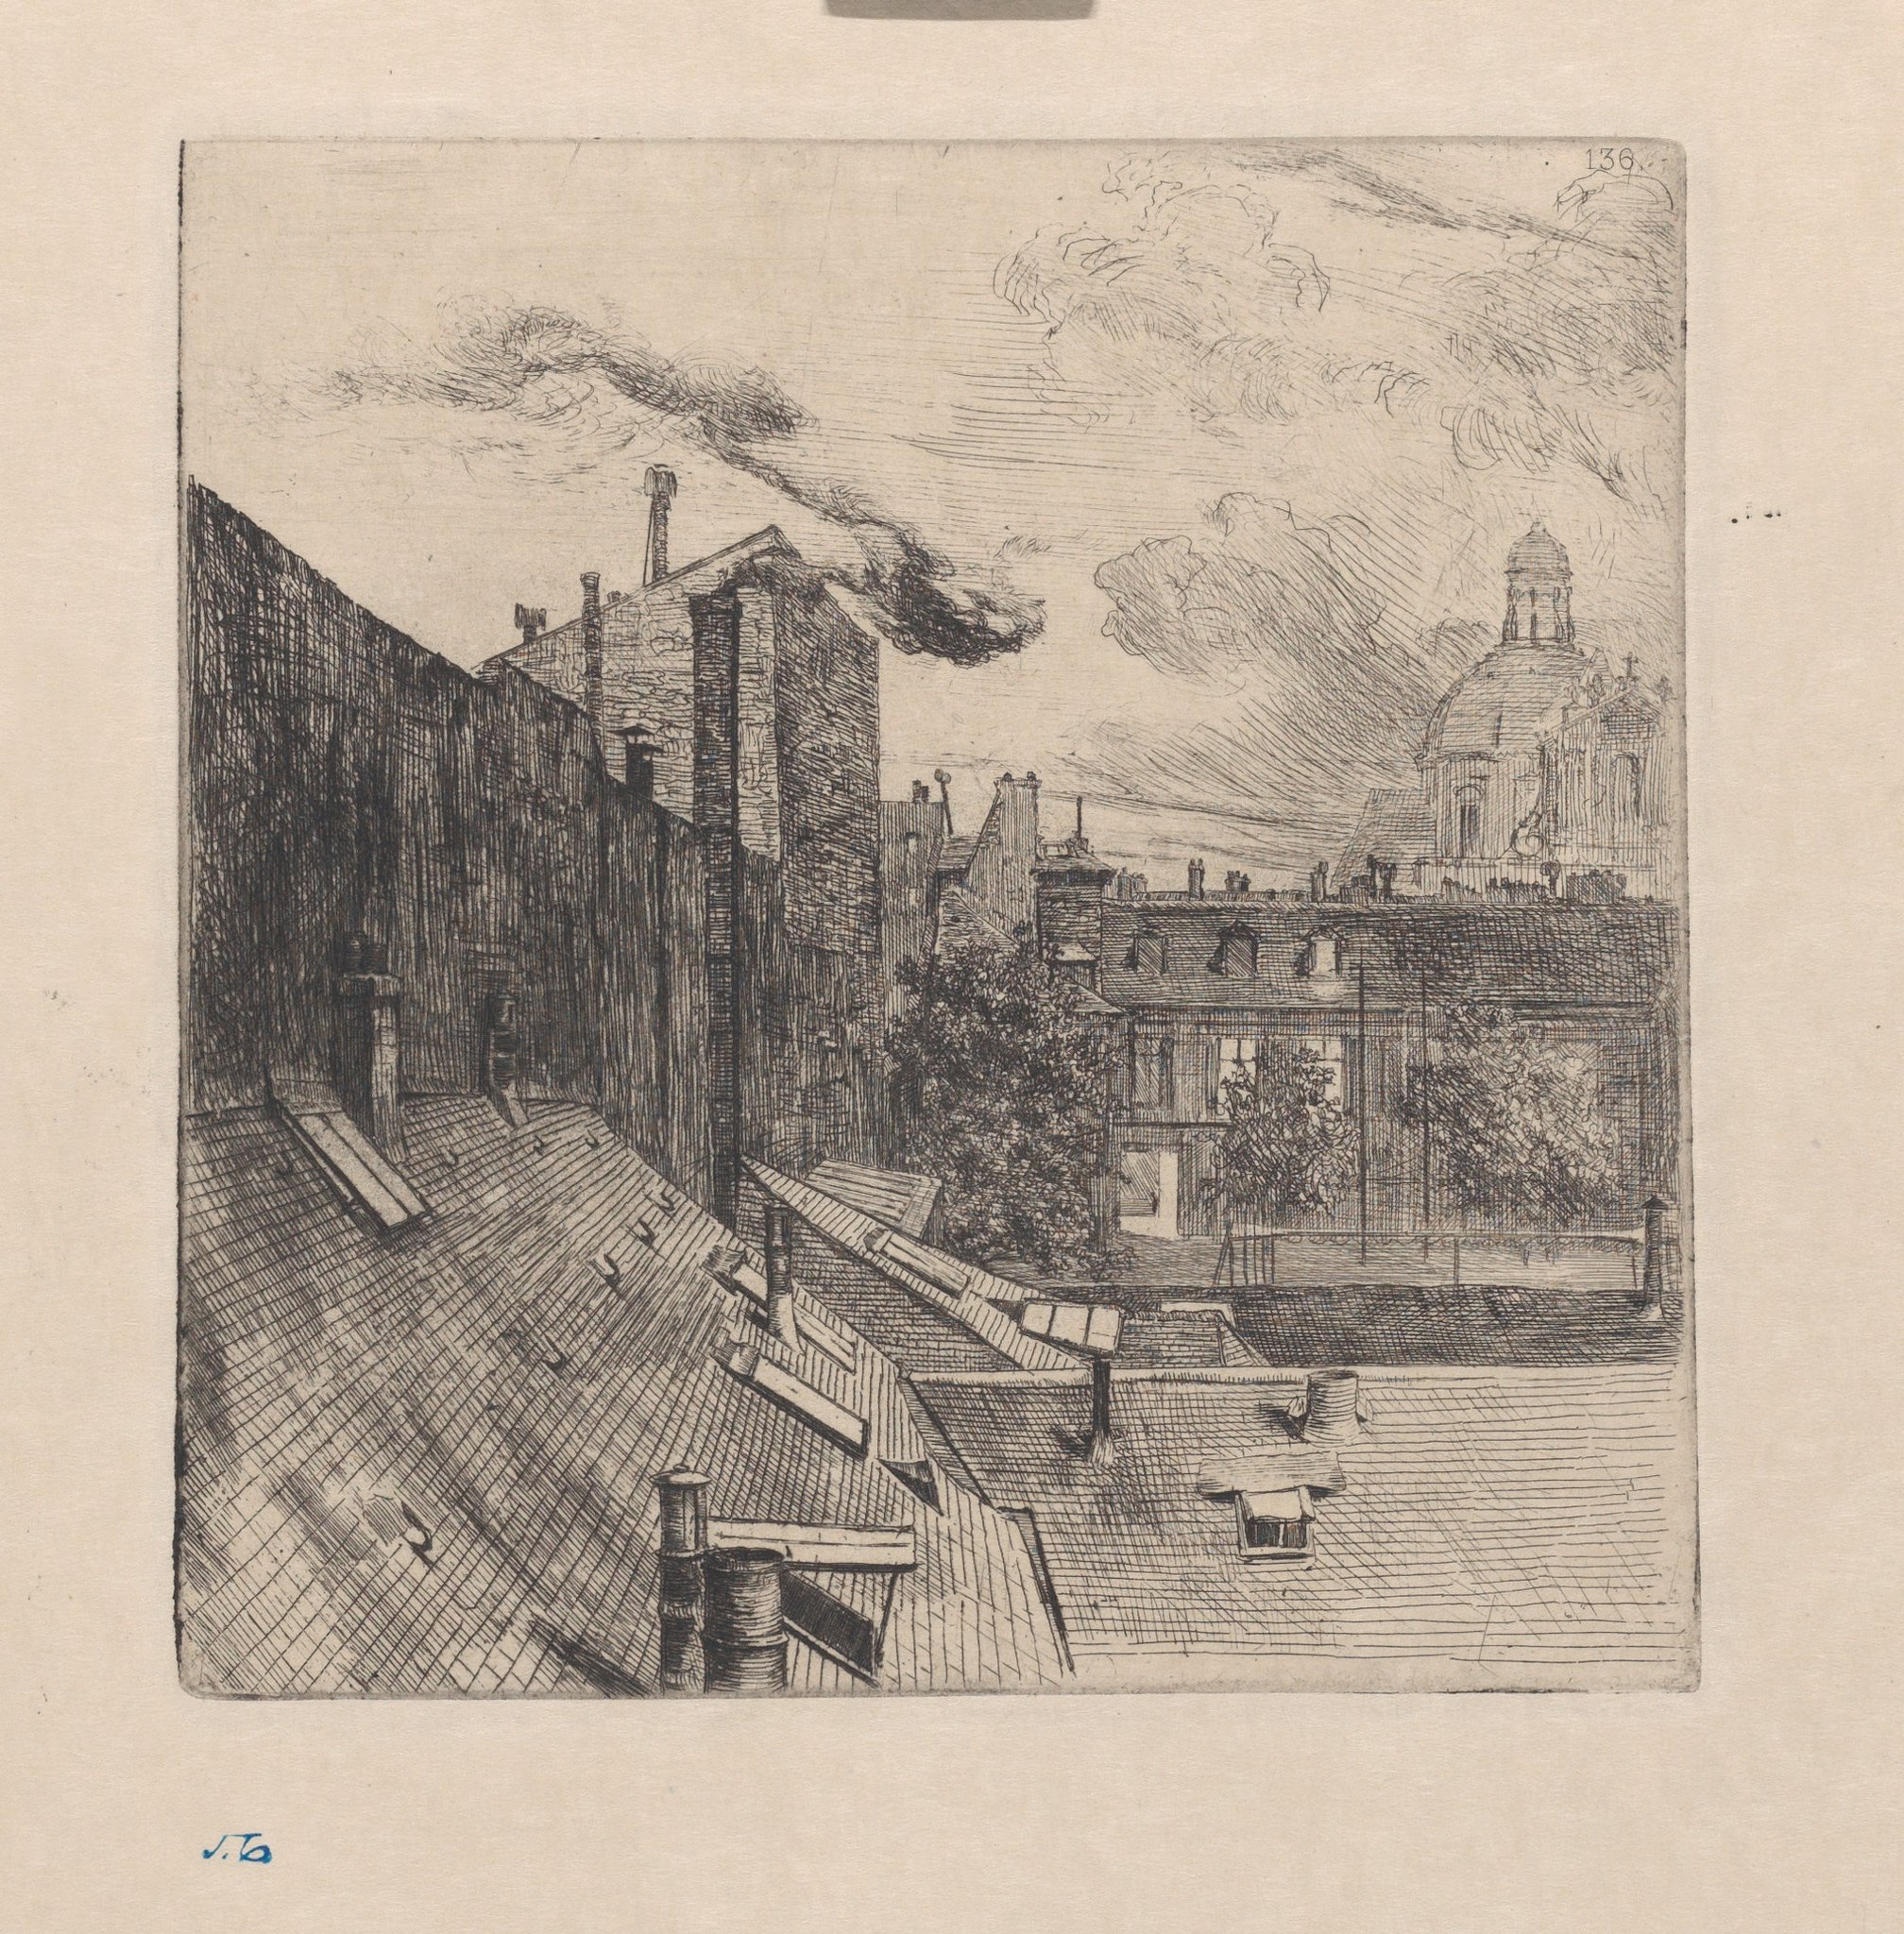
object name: print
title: View from the Artist's Window, rue Culture-Sainte-Catherine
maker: jules-ferdinand jacquemart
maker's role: artist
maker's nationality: french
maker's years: 1837-1880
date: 1865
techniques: etching